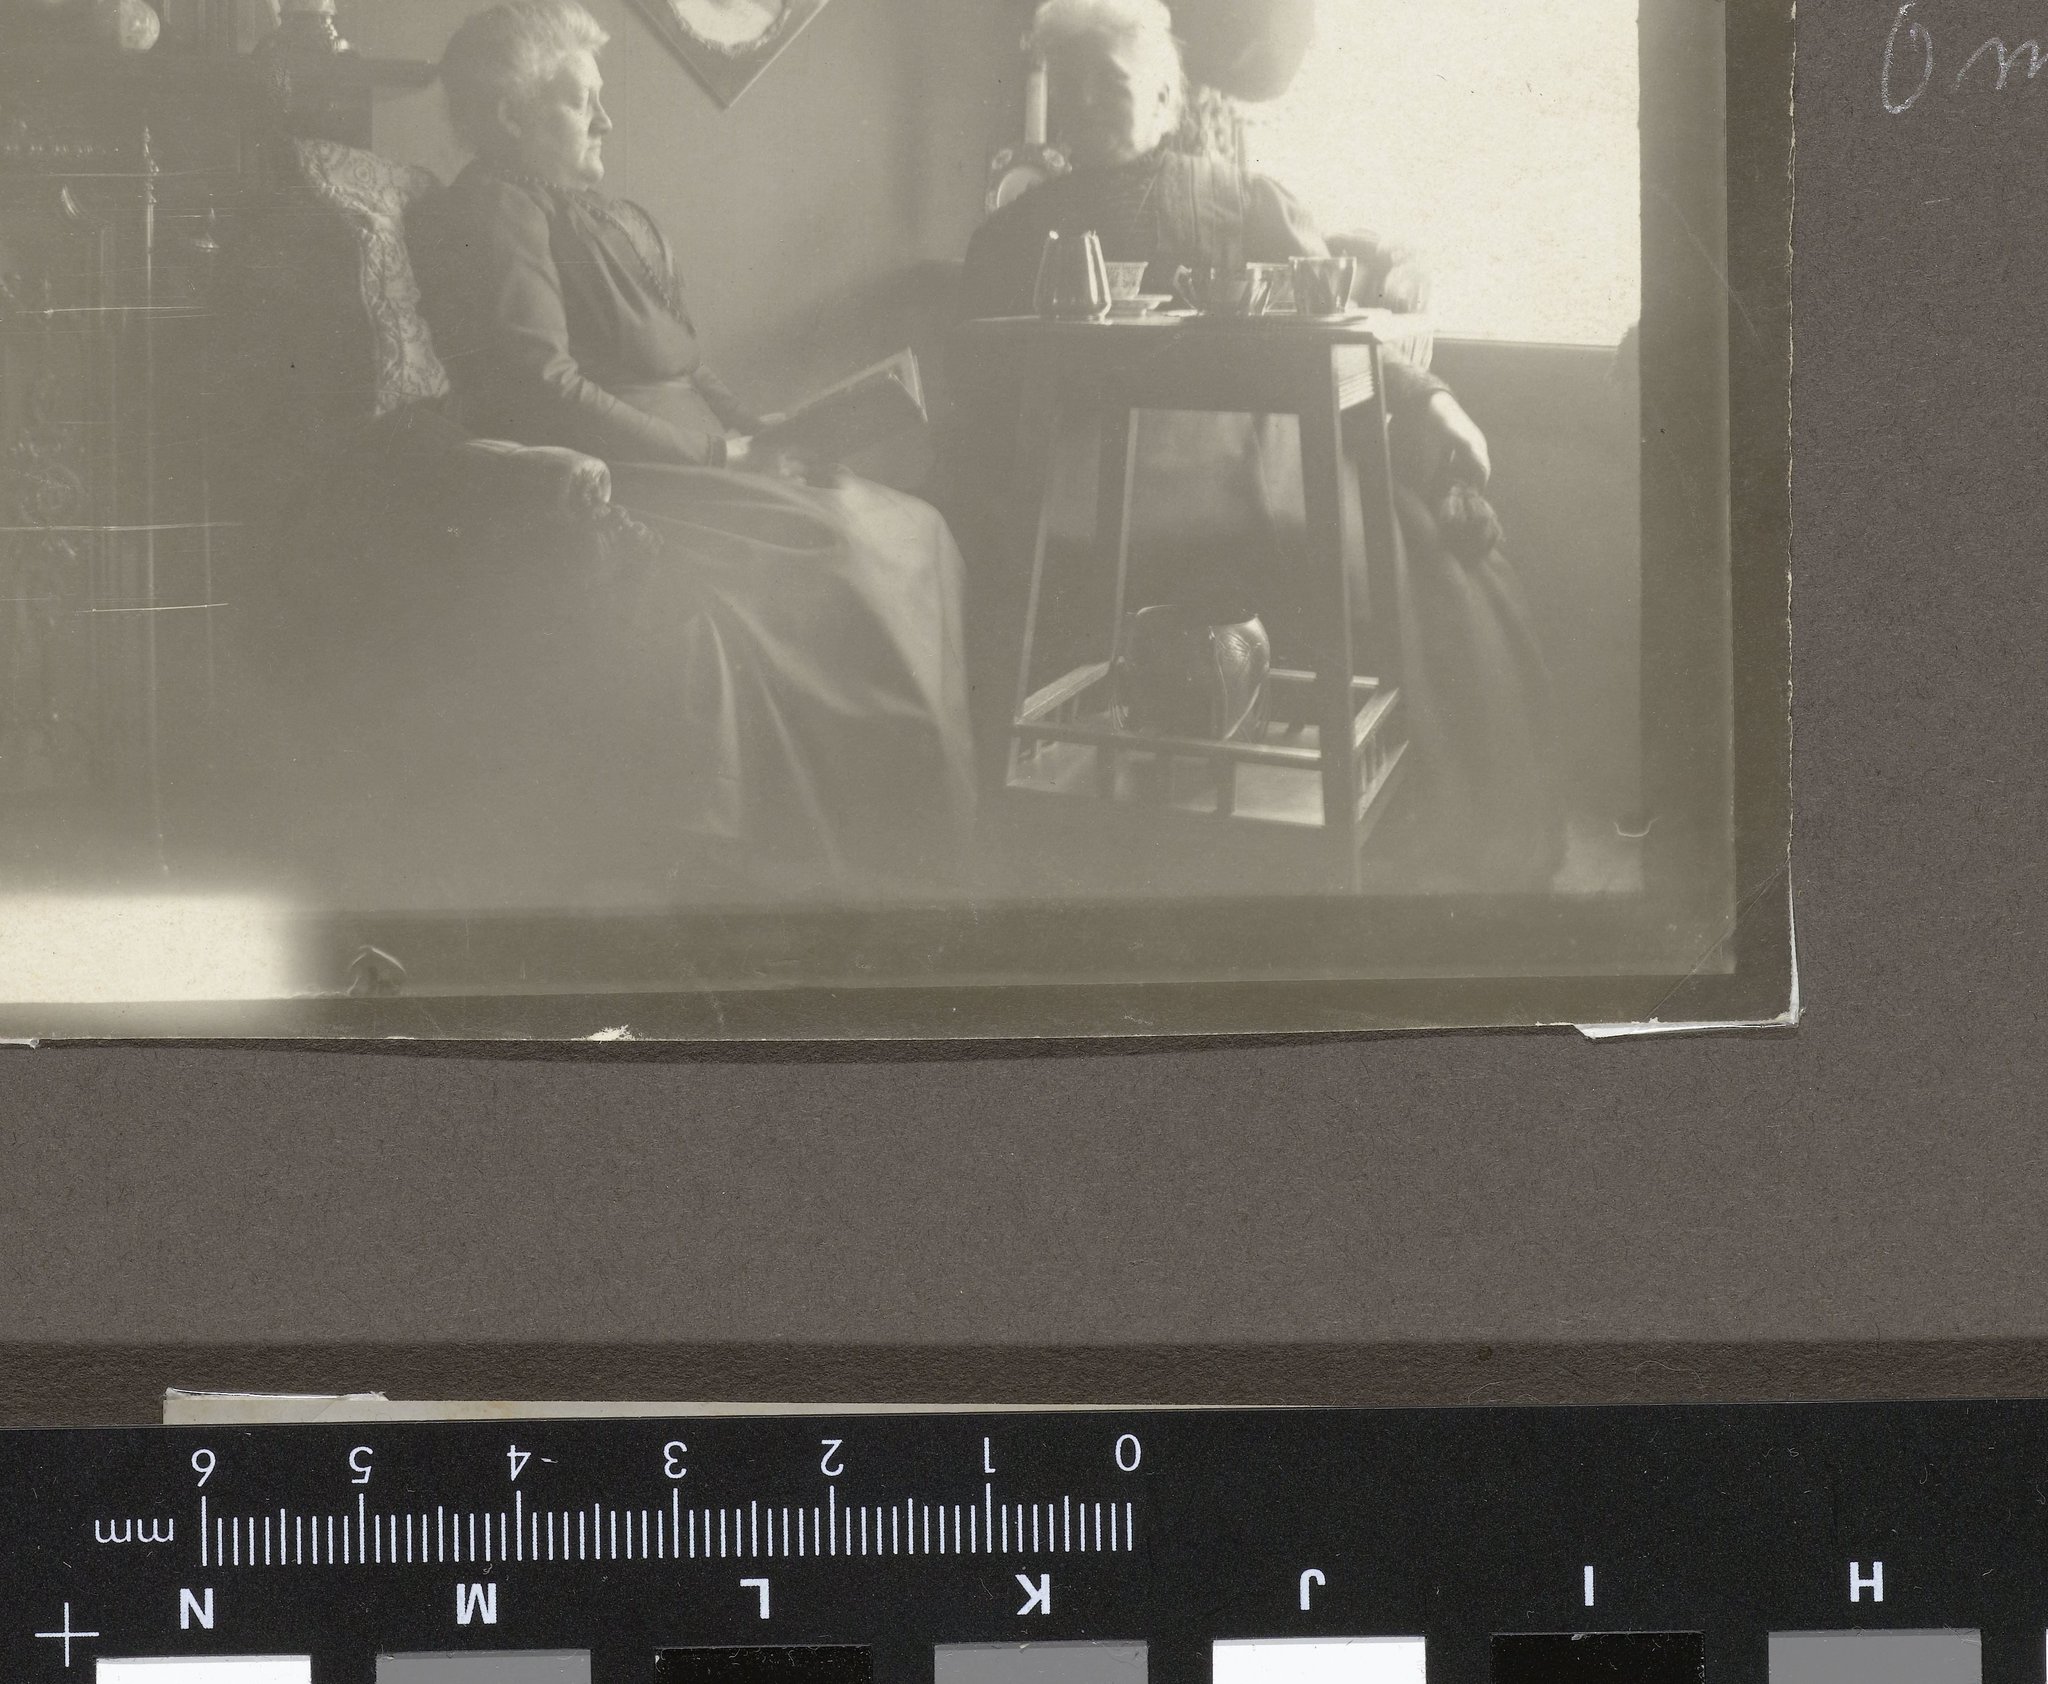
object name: album leaf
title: Grietje Vermeulen-Luitjes en een andere vrouw lezen aan tafel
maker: cornelis johannes lodewicus vermeulen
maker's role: fotograaf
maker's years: 1861-1936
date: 1900-1925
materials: paper, cardboard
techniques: gelatin silver print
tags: reading, adult woman (+ two persons)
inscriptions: inscription: ‘oma’